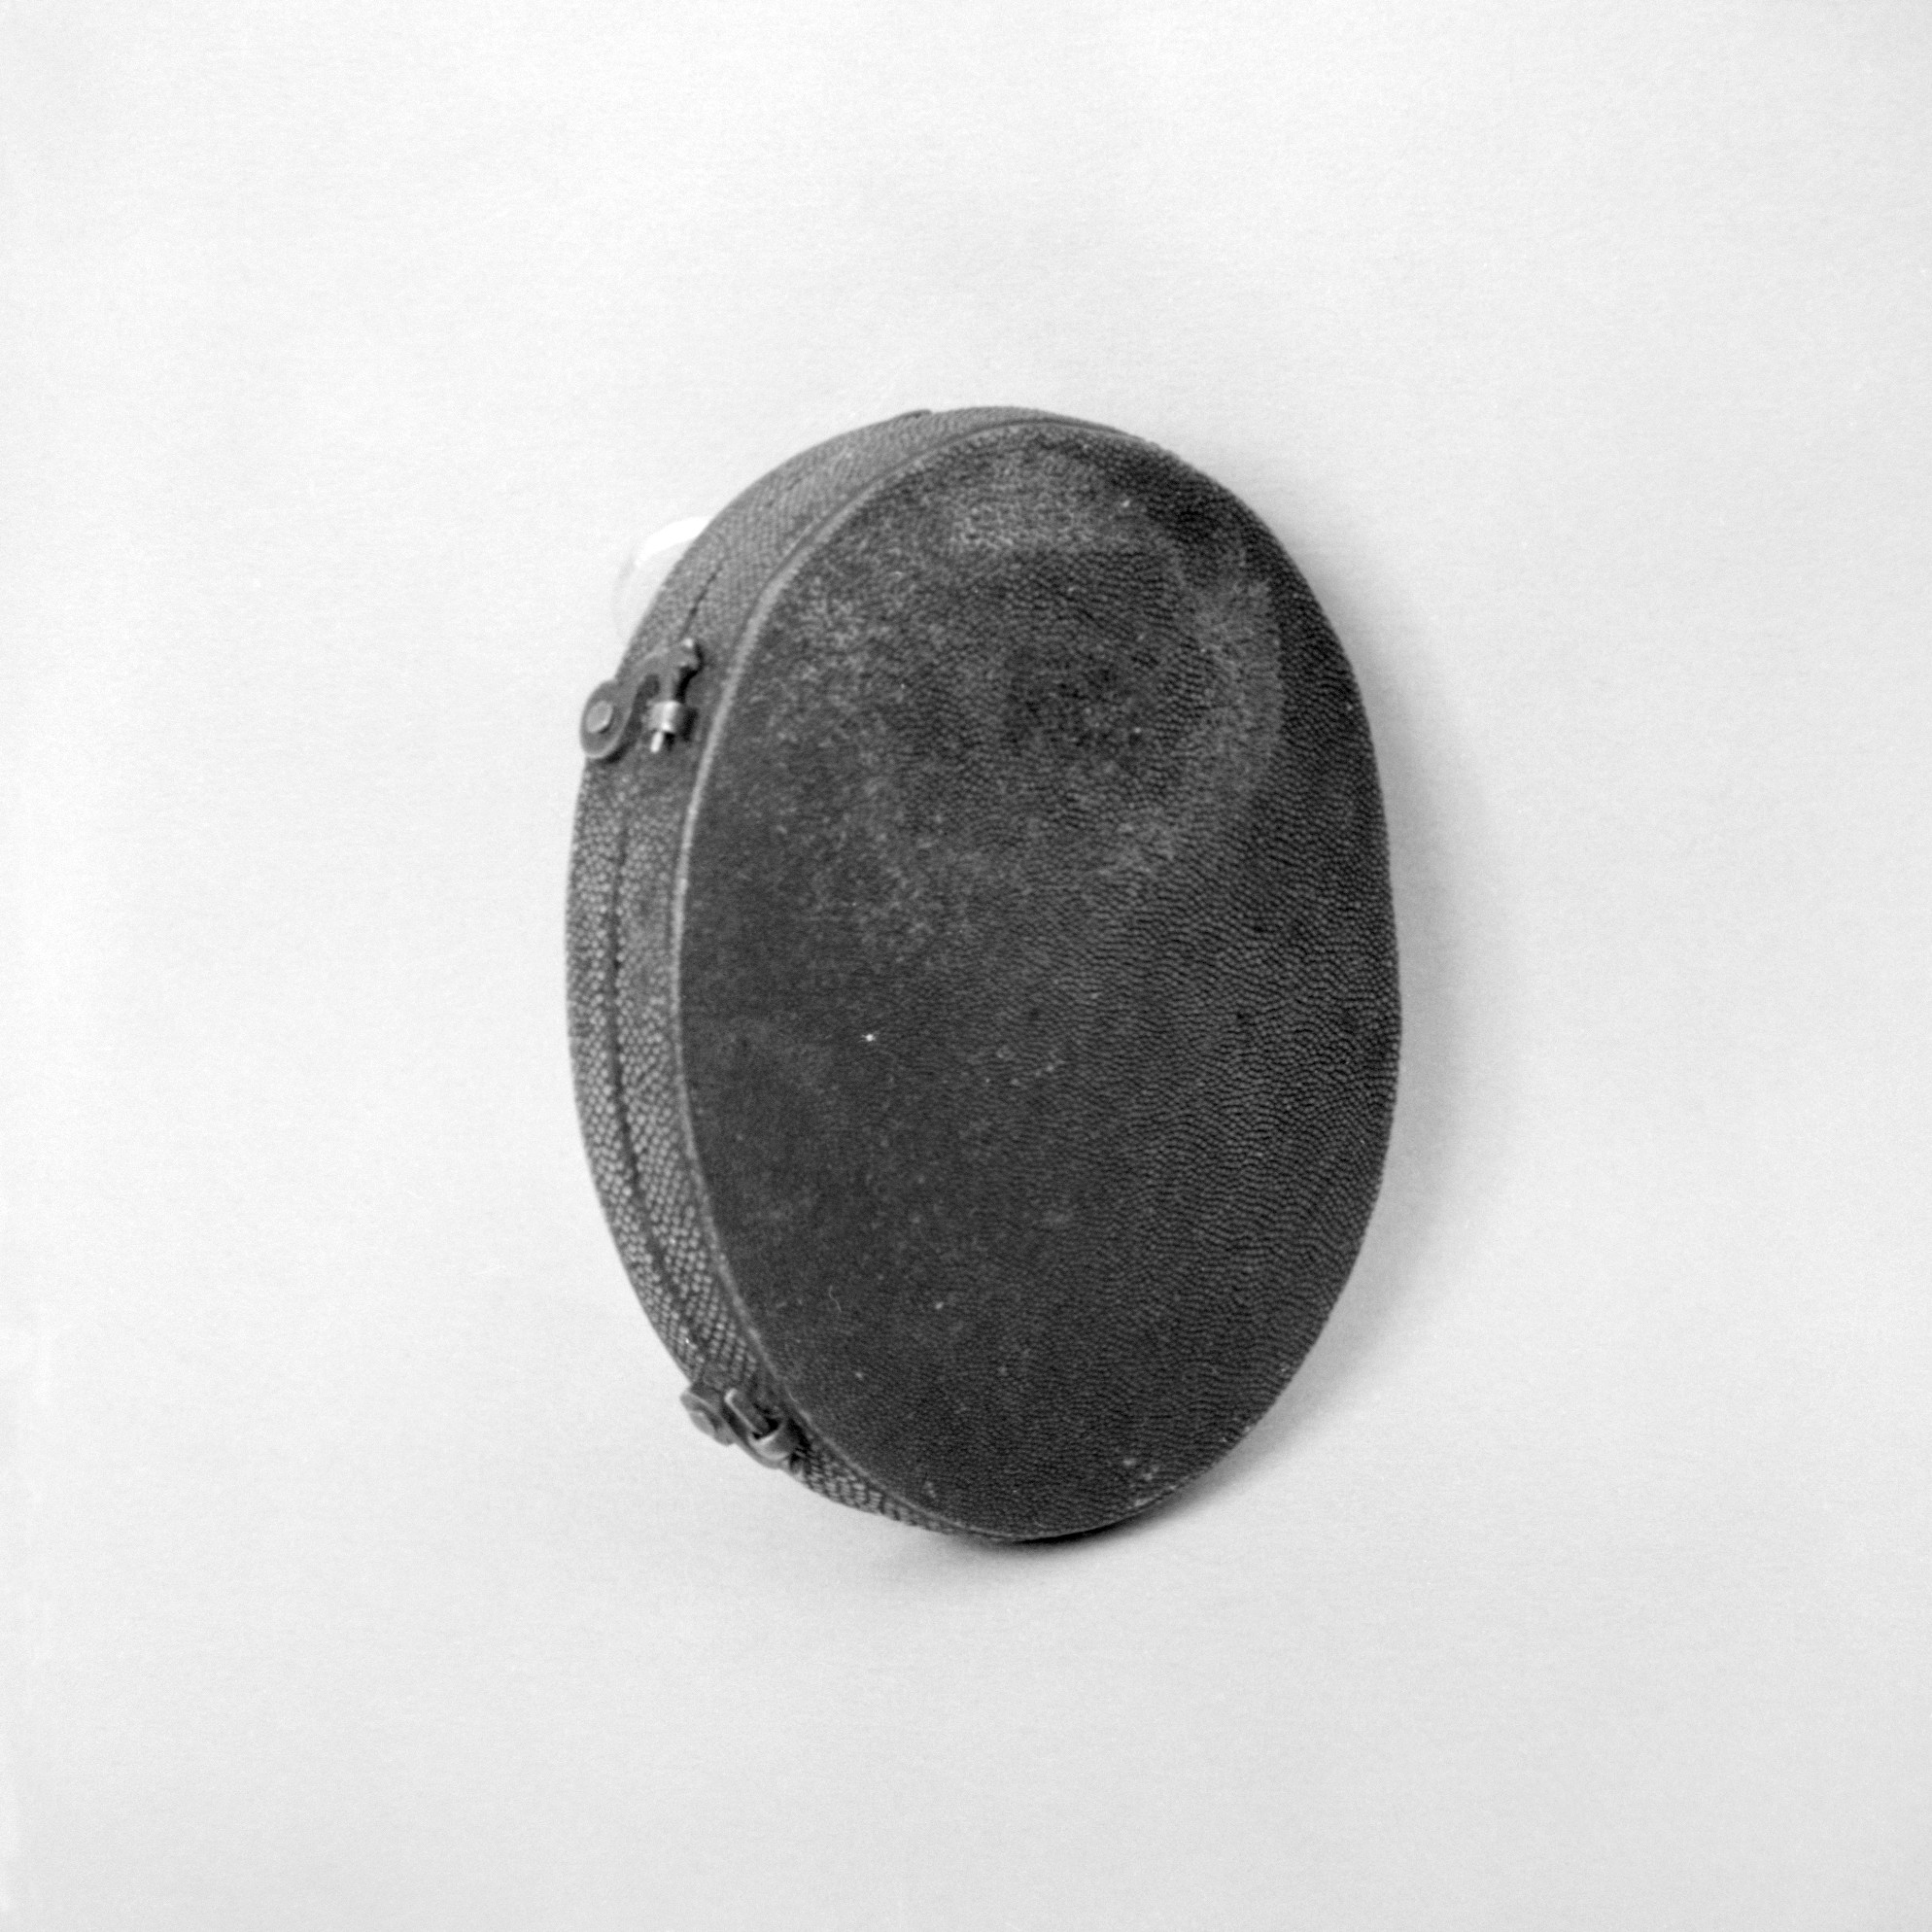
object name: case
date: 1701-1800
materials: velvet